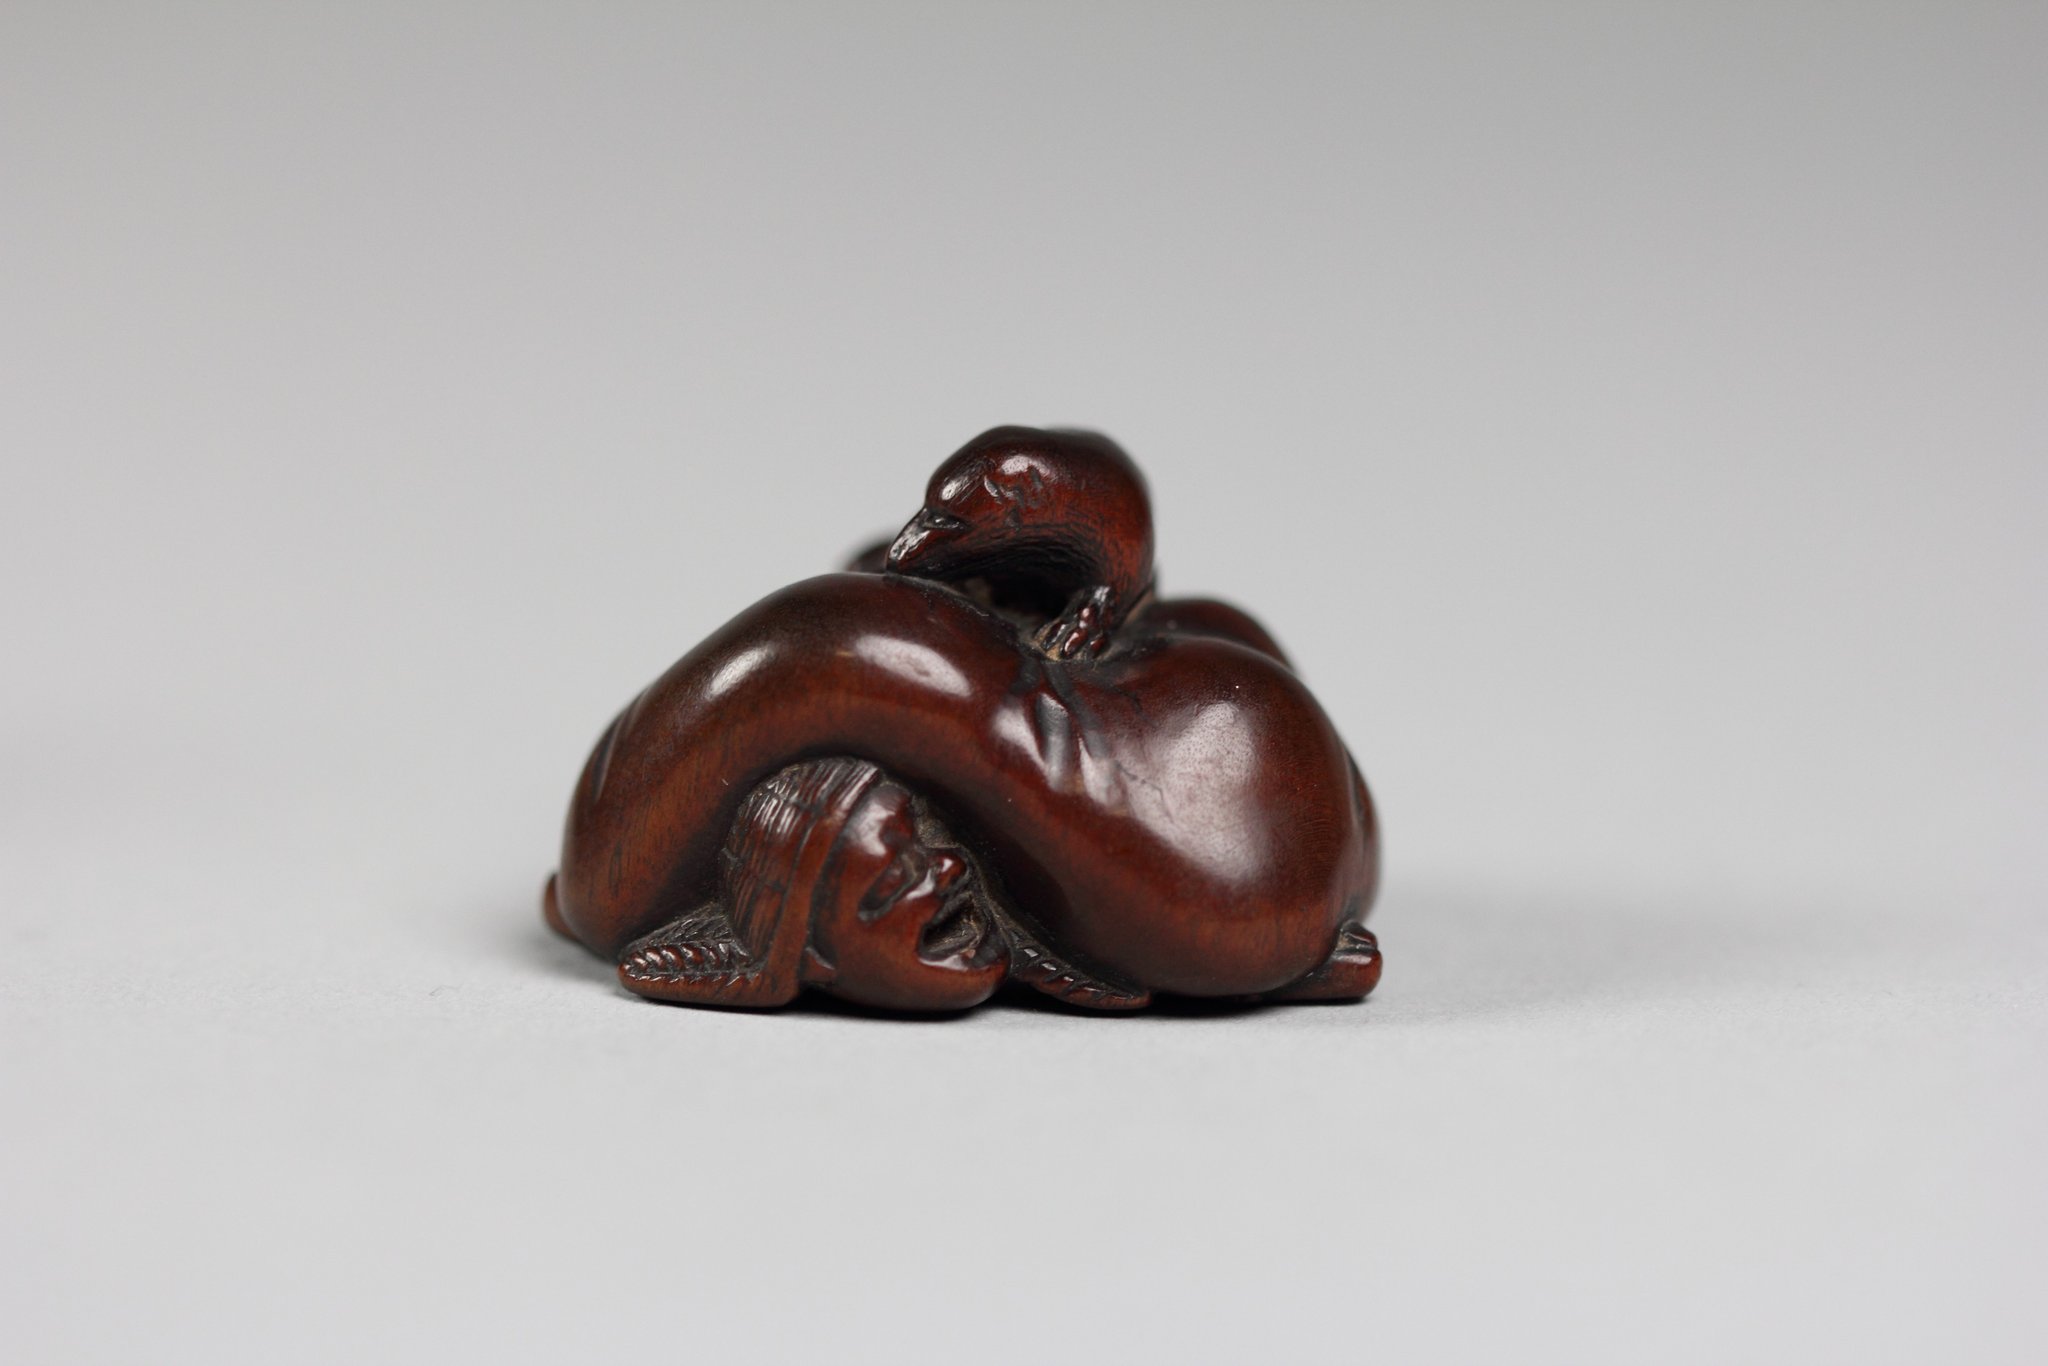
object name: netsuke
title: Netsuke: Hachi Jo Jiki Kintama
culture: japanese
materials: wood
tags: bears,men